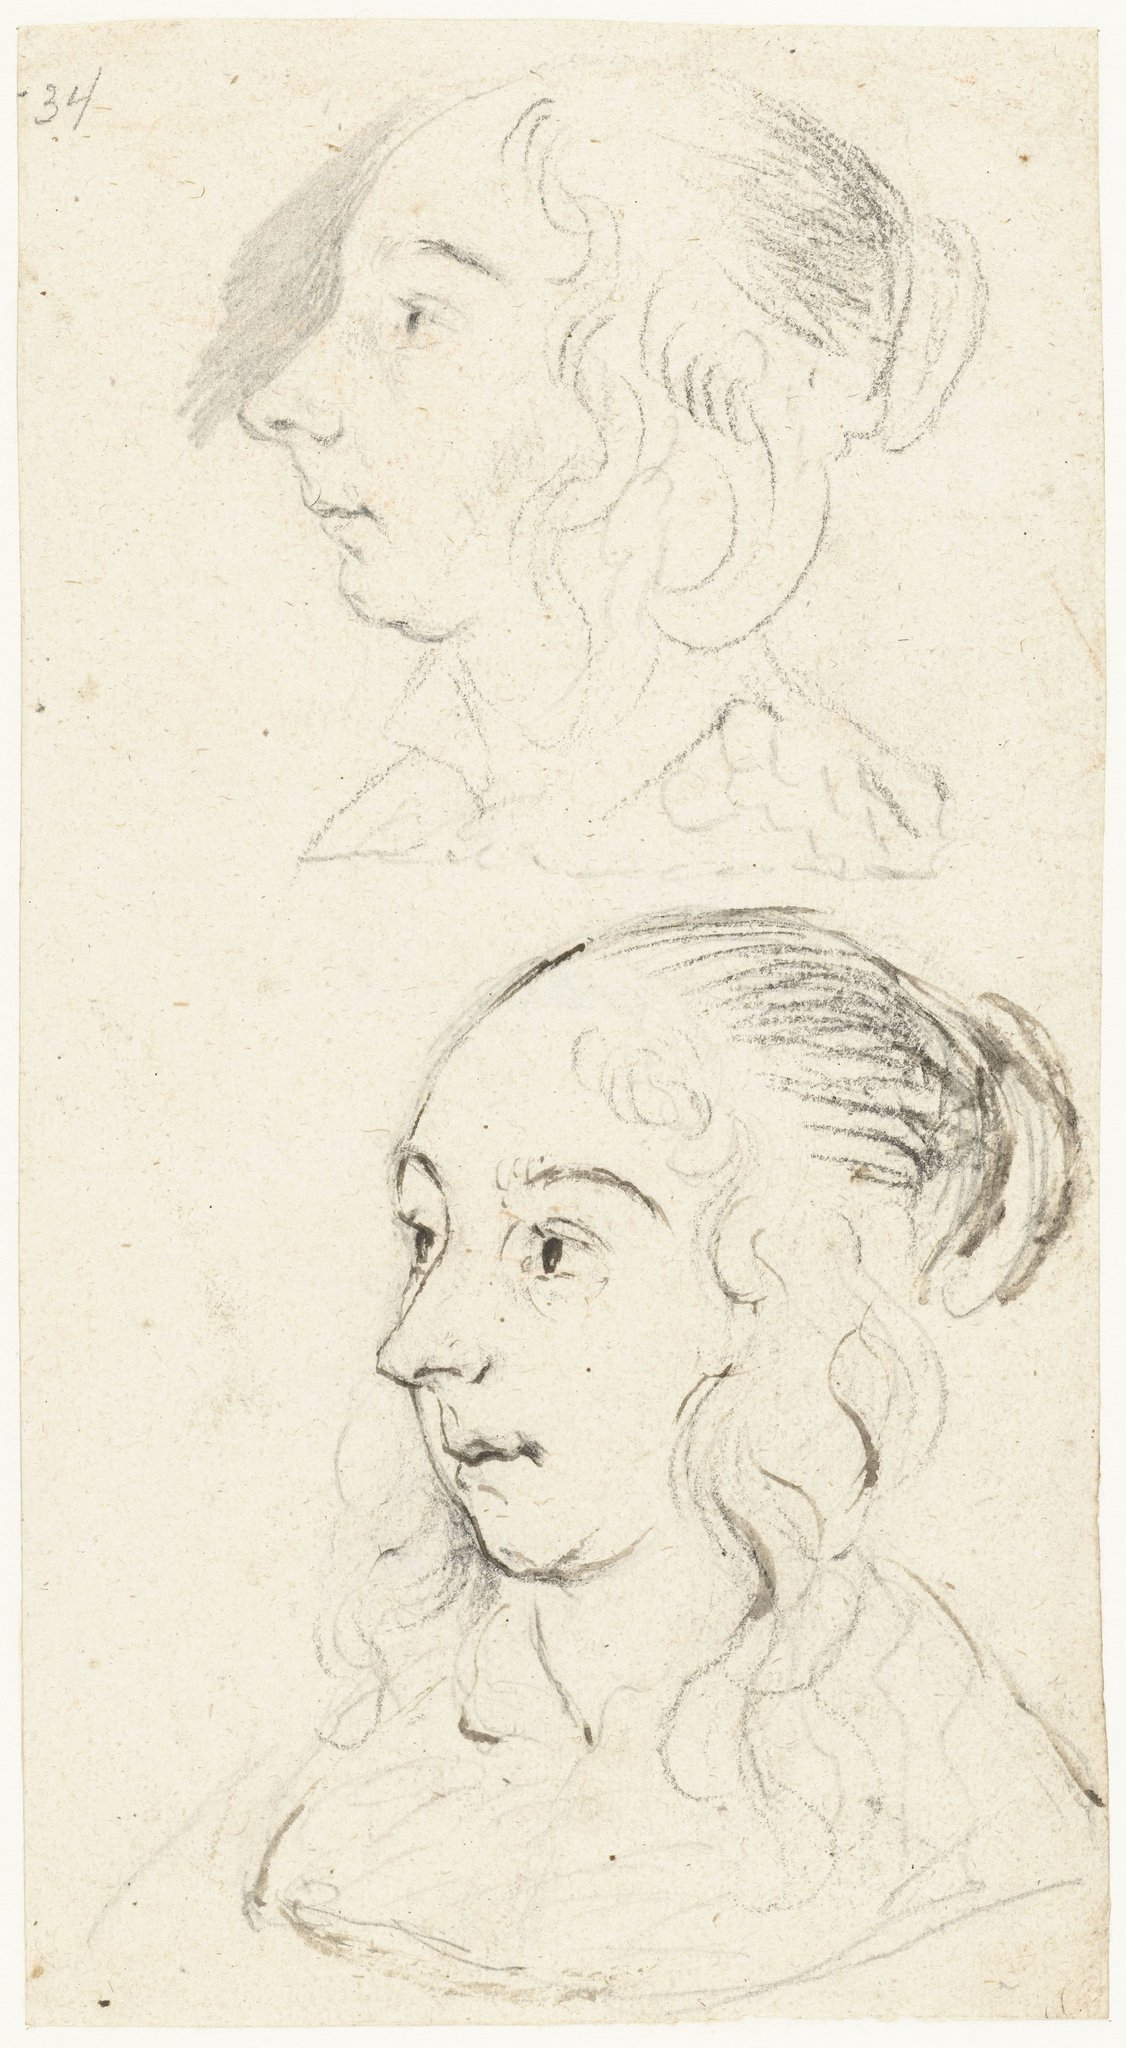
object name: drawing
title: Two Studies of Gesina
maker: gerard ter borch (ii)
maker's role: draughtsman, painter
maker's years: 1617-1681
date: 1645-1660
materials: chalk, ink, paper, pencil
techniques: brush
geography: zwolle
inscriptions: annotation: ‘Ger.Jr.’